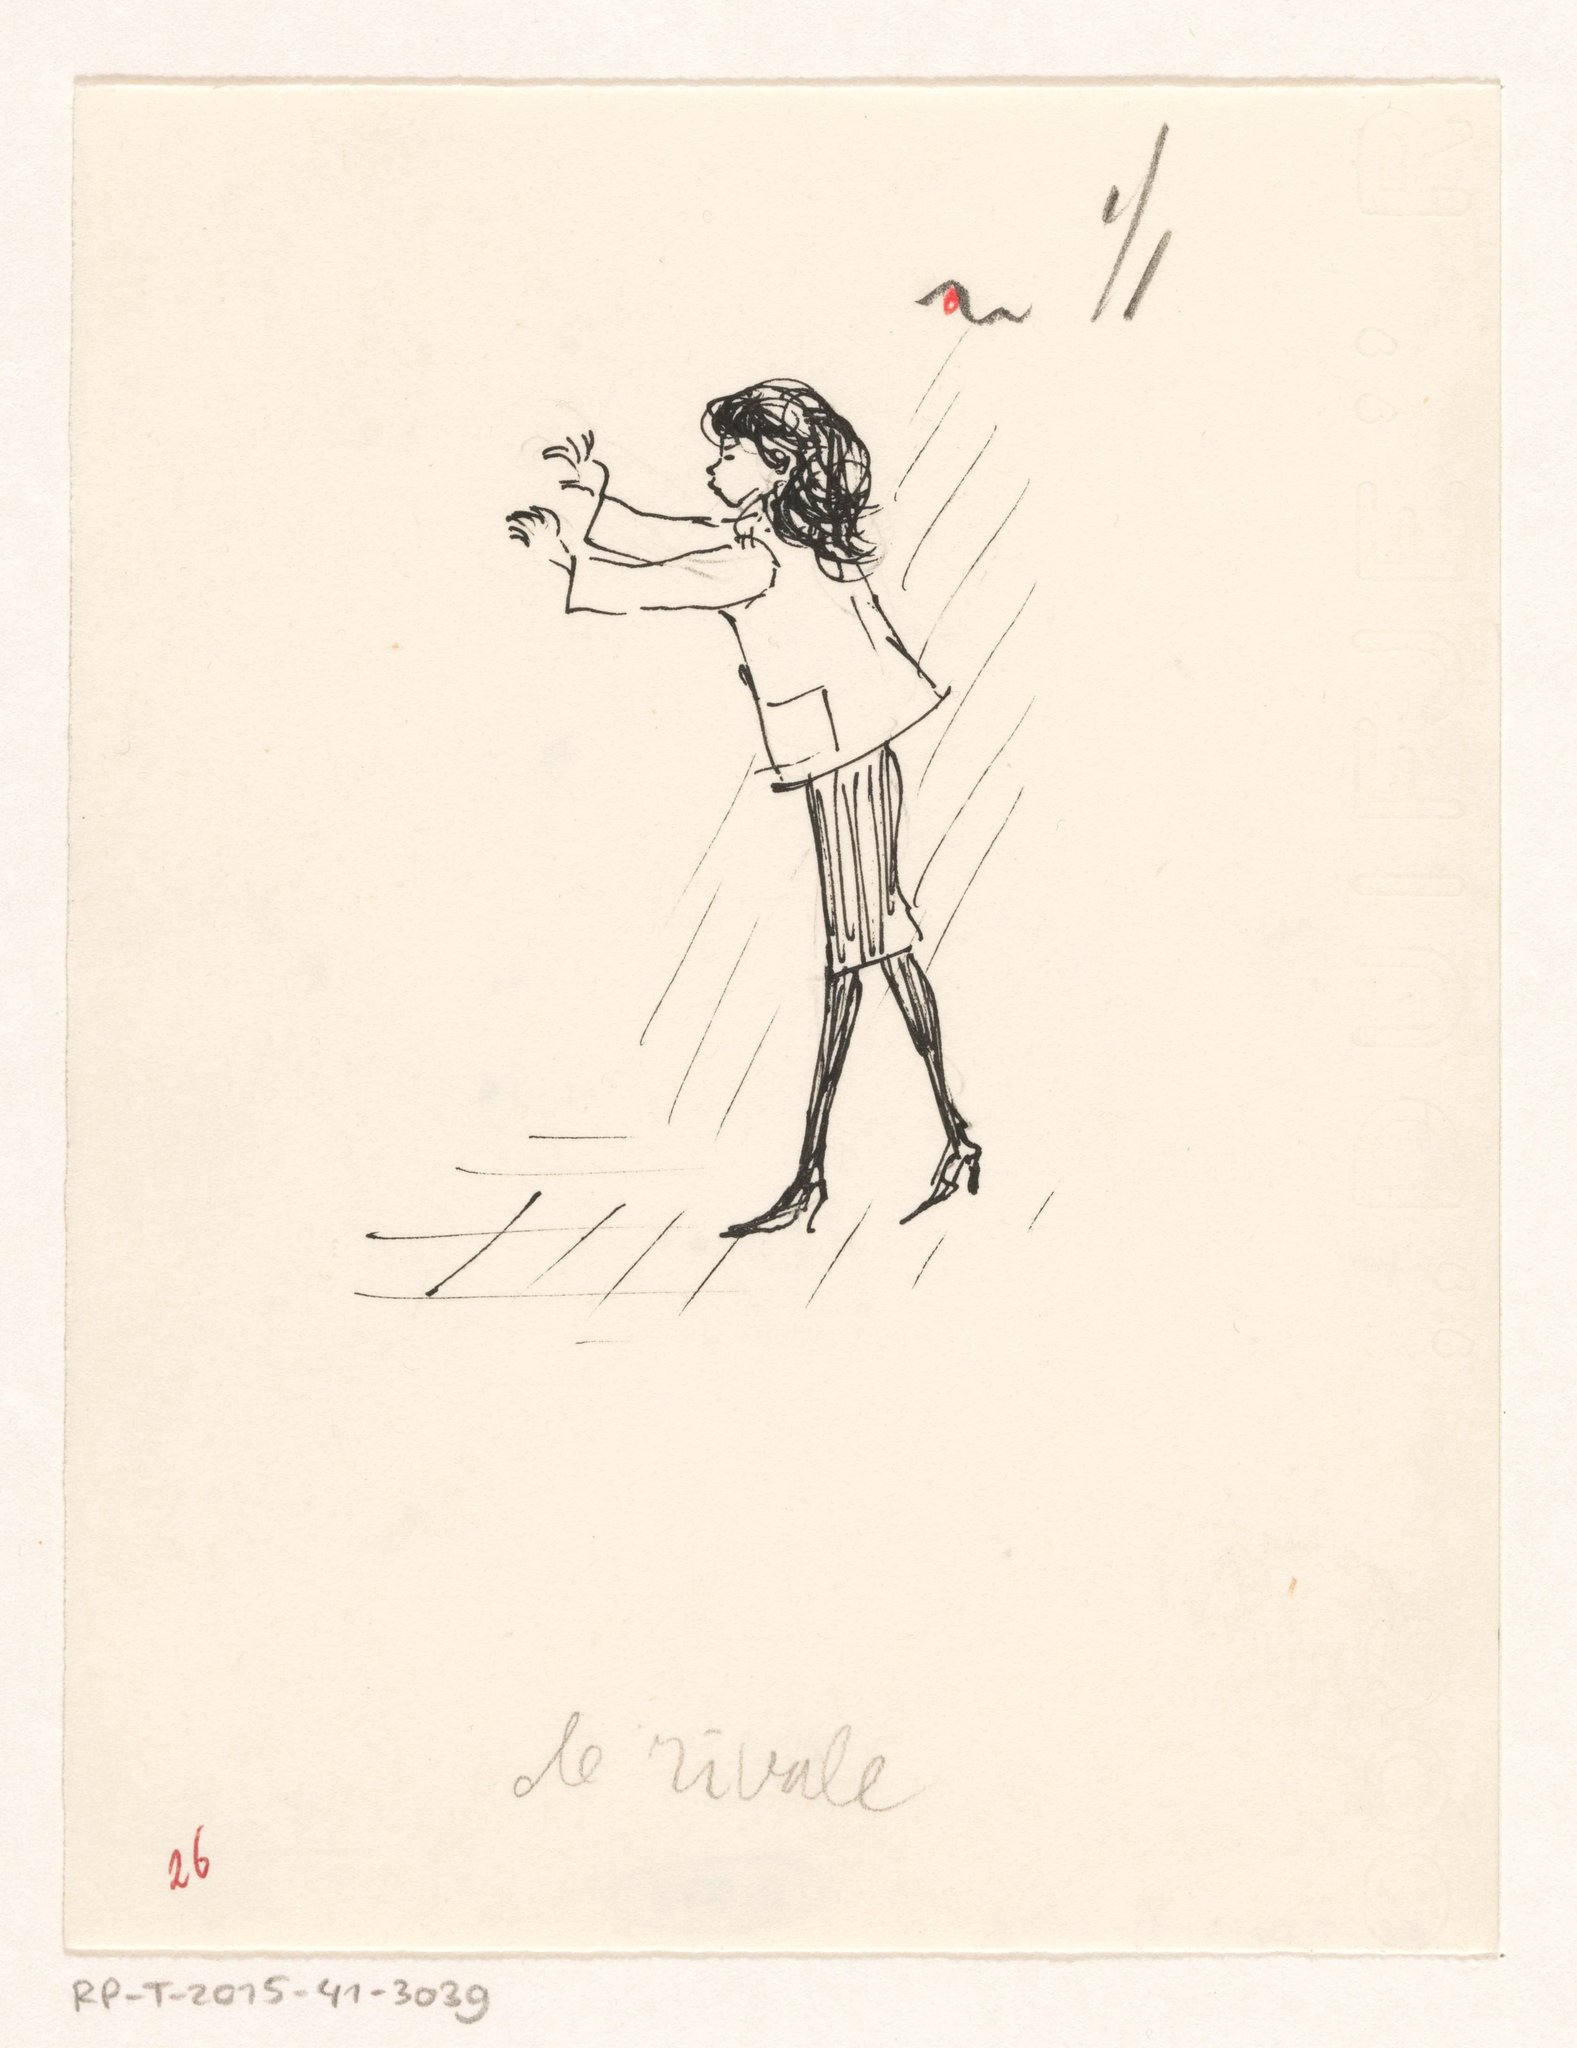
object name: drawing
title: Jonge vrouw met uitgestrekte armen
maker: Anonymous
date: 1930-1970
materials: ink, paper, pencil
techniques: pen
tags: adolescent, young woman, maiden, arm stretched forward - aa - both arms or hands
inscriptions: number: ‘26’, :, collector's mark: Lugt 2228a, factory mark: ‘606 '' DUIFJE " R’, annotation: ‘de rivale’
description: Een jonge vrouw staat op straat met uitgestrekte armen. Ze maakt een grijpbeweging met haar vingers.